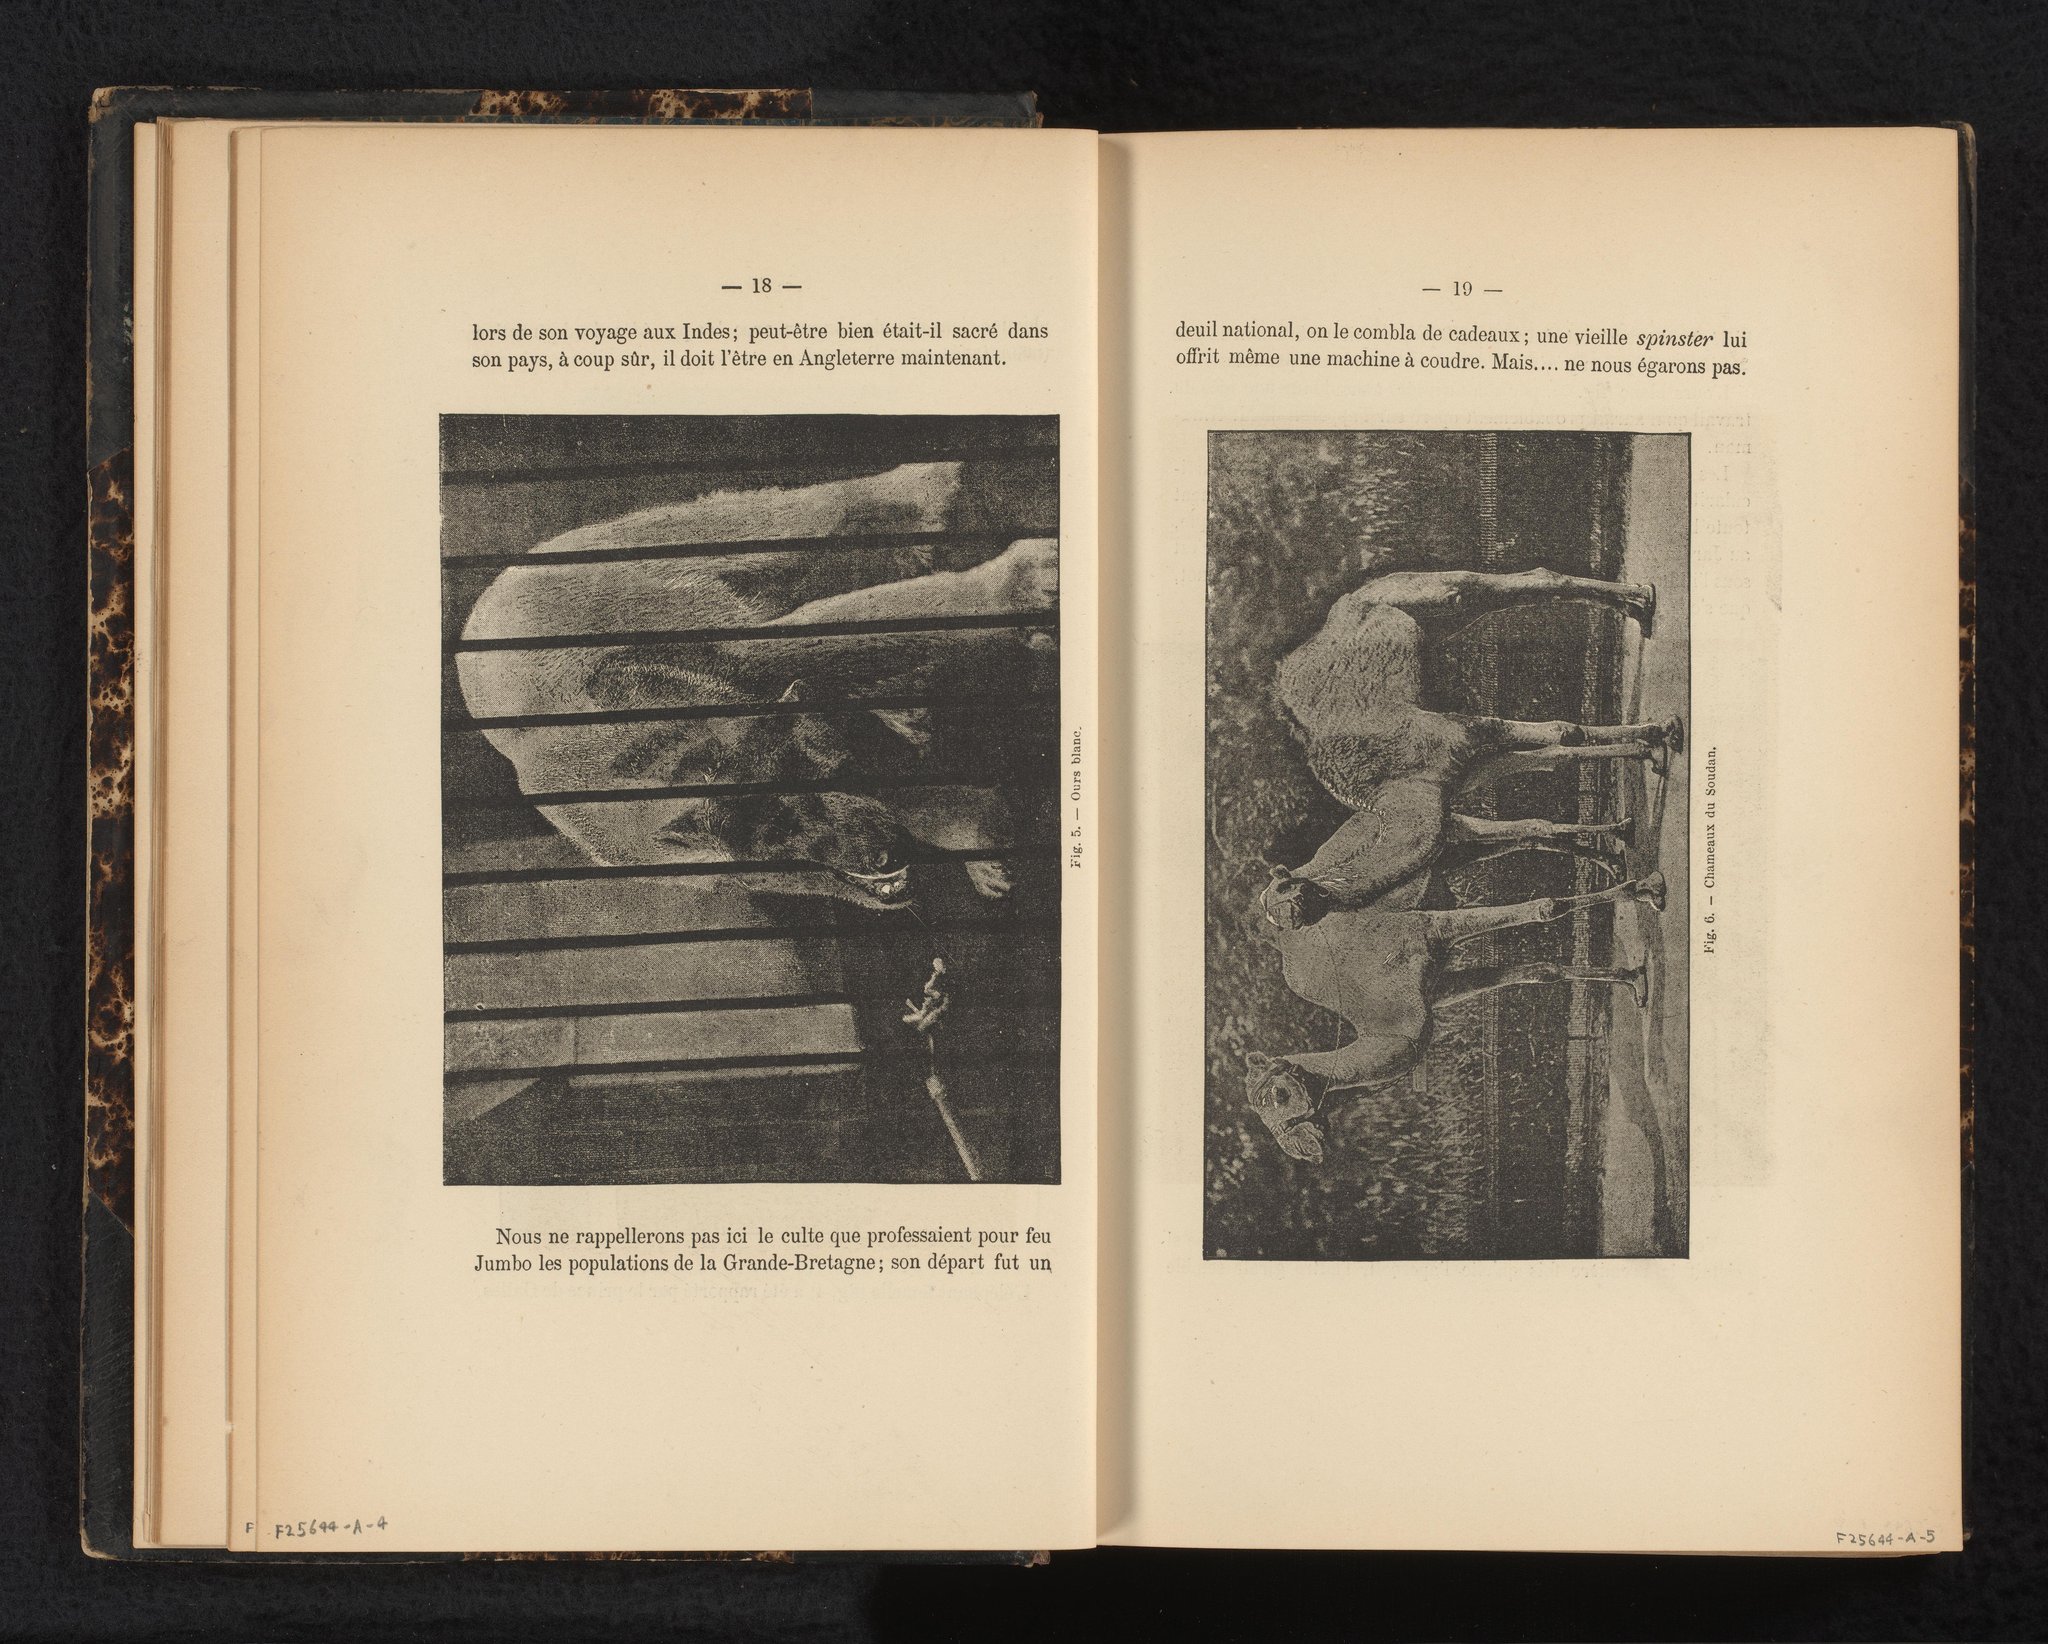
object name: photomechanical print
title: Dromedarissen in de London Zoo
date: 1882-1887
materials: paper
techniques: autotype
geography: london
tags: hoofed animals: dromedary